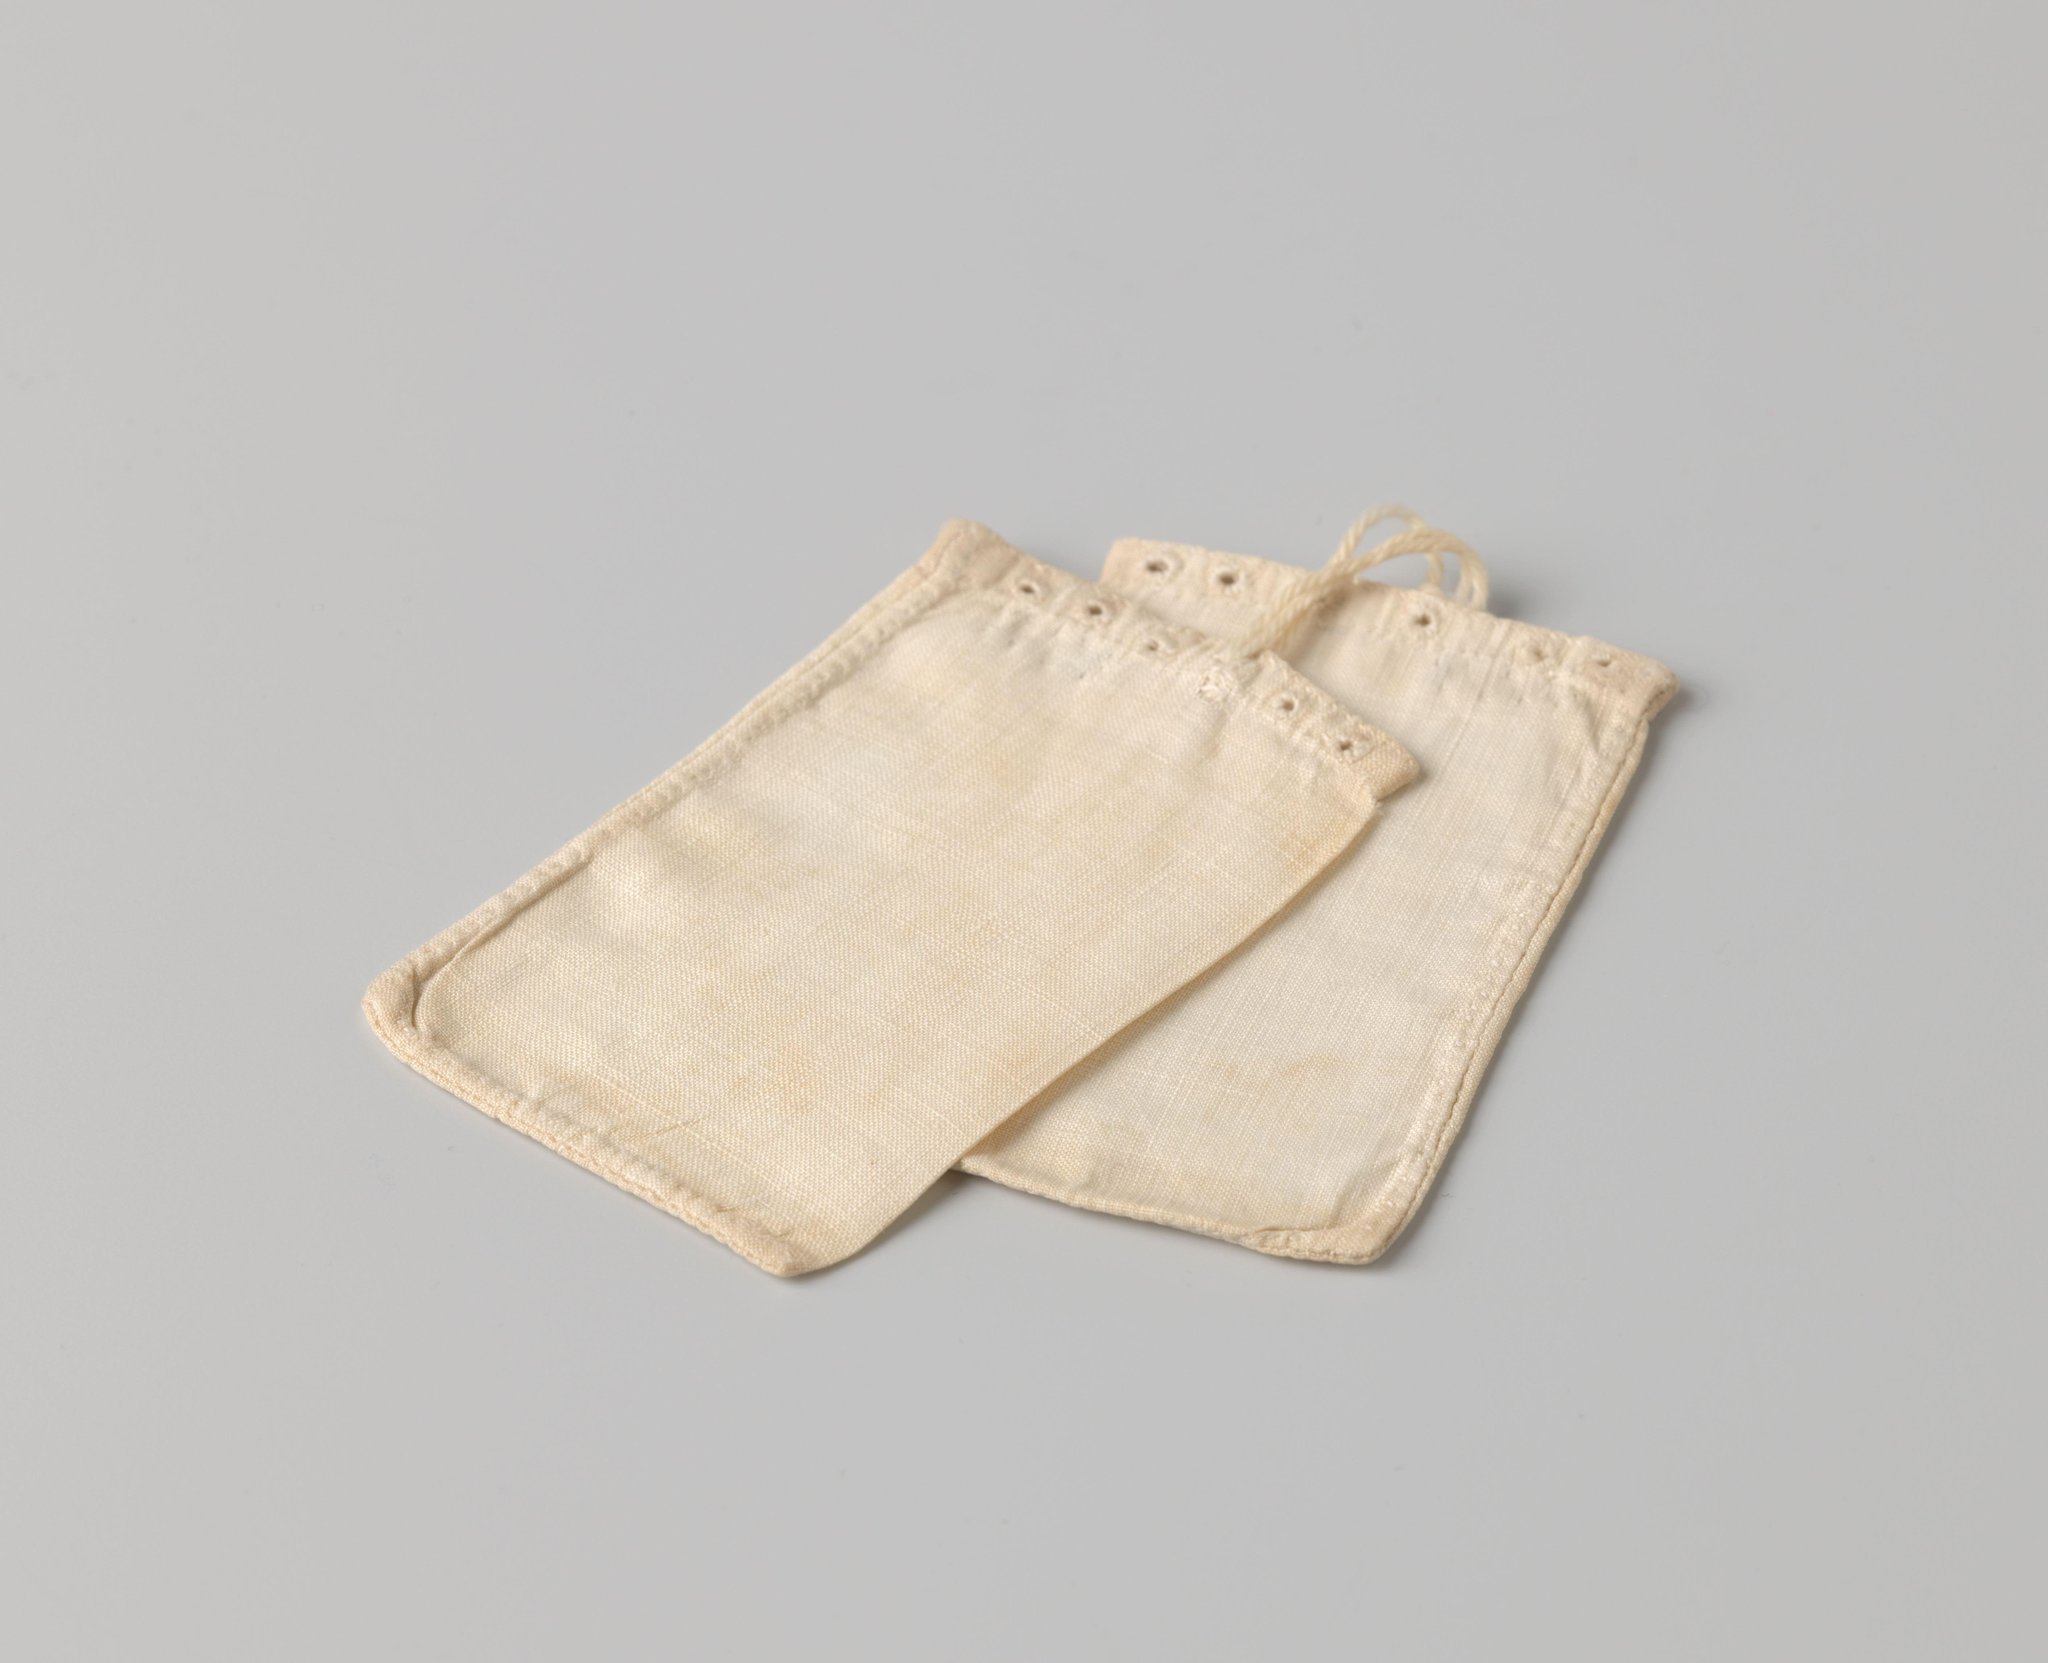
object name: sloop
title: Sloop met koordsluiting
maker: Anonymous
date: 1750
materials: linen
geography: netherlands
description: Sloop voor kussen, aan korte zijde voorzien van zes gaten voor koordsluiting.